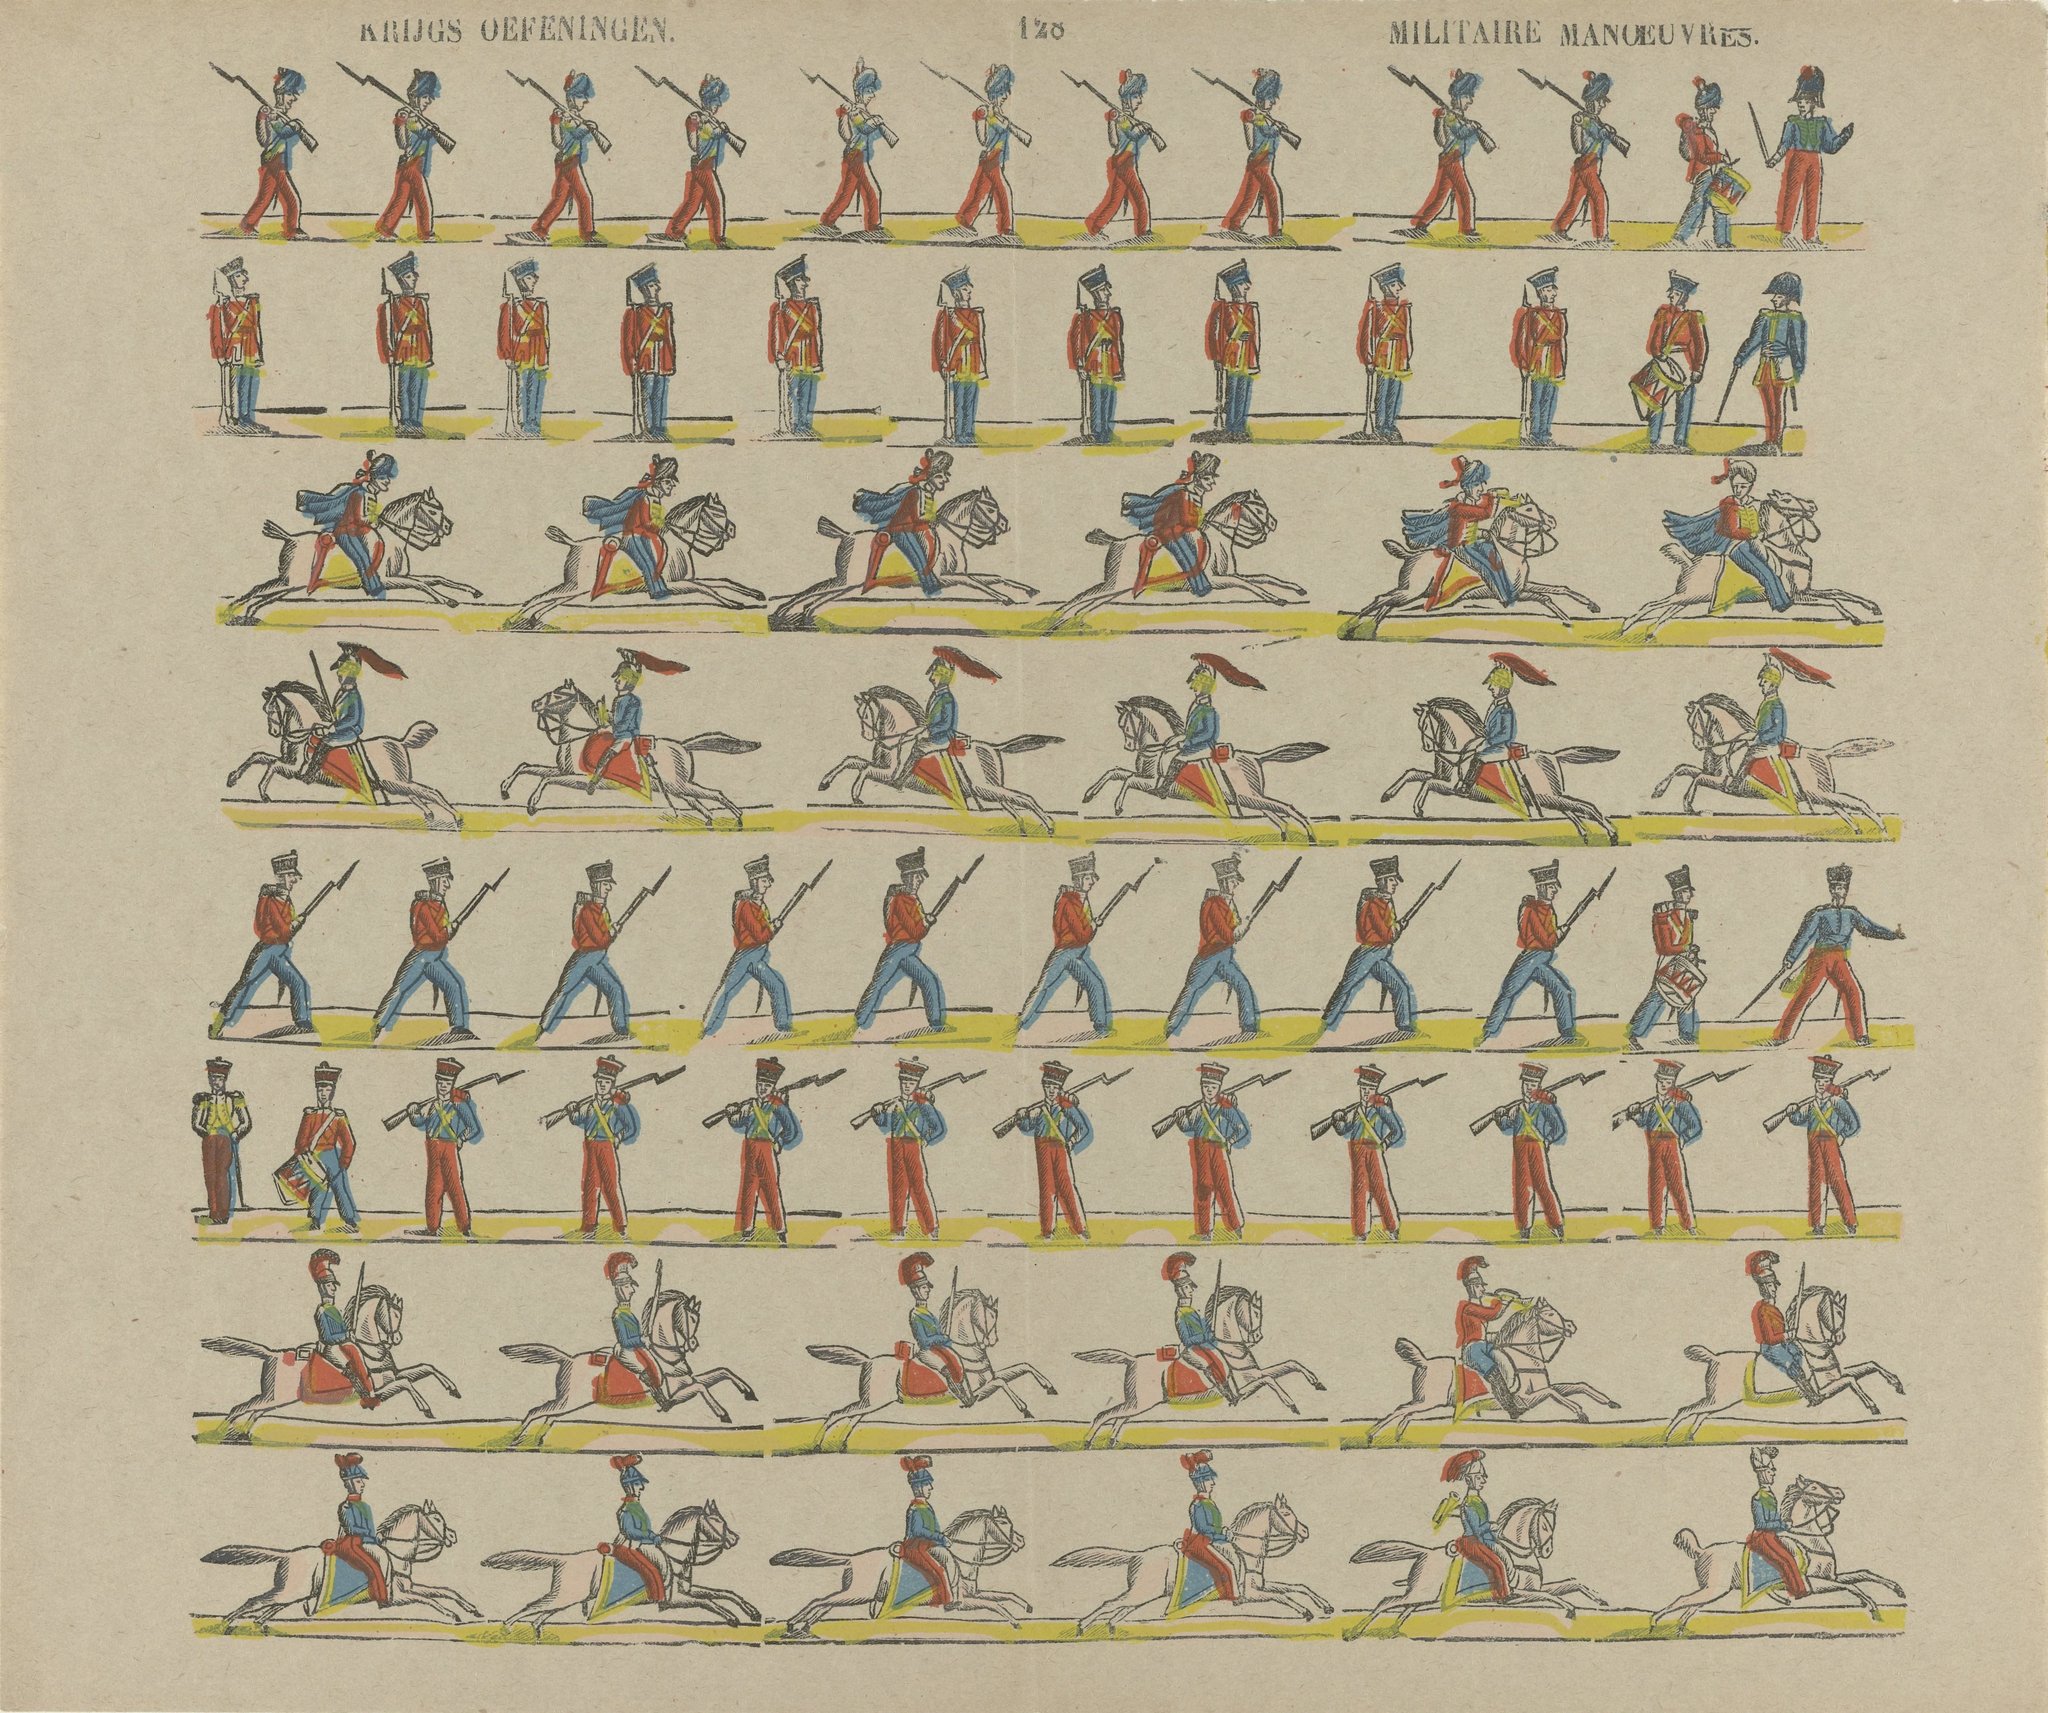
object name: popular print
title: Krijgs oefeningen / Militaire manoeuvres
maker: Anonymous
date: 1833-1911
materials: paper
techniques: lithograph, letterpress printing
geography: turnhout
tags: warfare; military affairs (+ cavalry, horsemen), the soldier; the soldier's life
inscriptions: collector's mark: Lugt 2760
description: Blad met 8 horizontale rijen met voorstellingen van militairen met wapens en militairen te paard. Genummerd midden boven: 128.